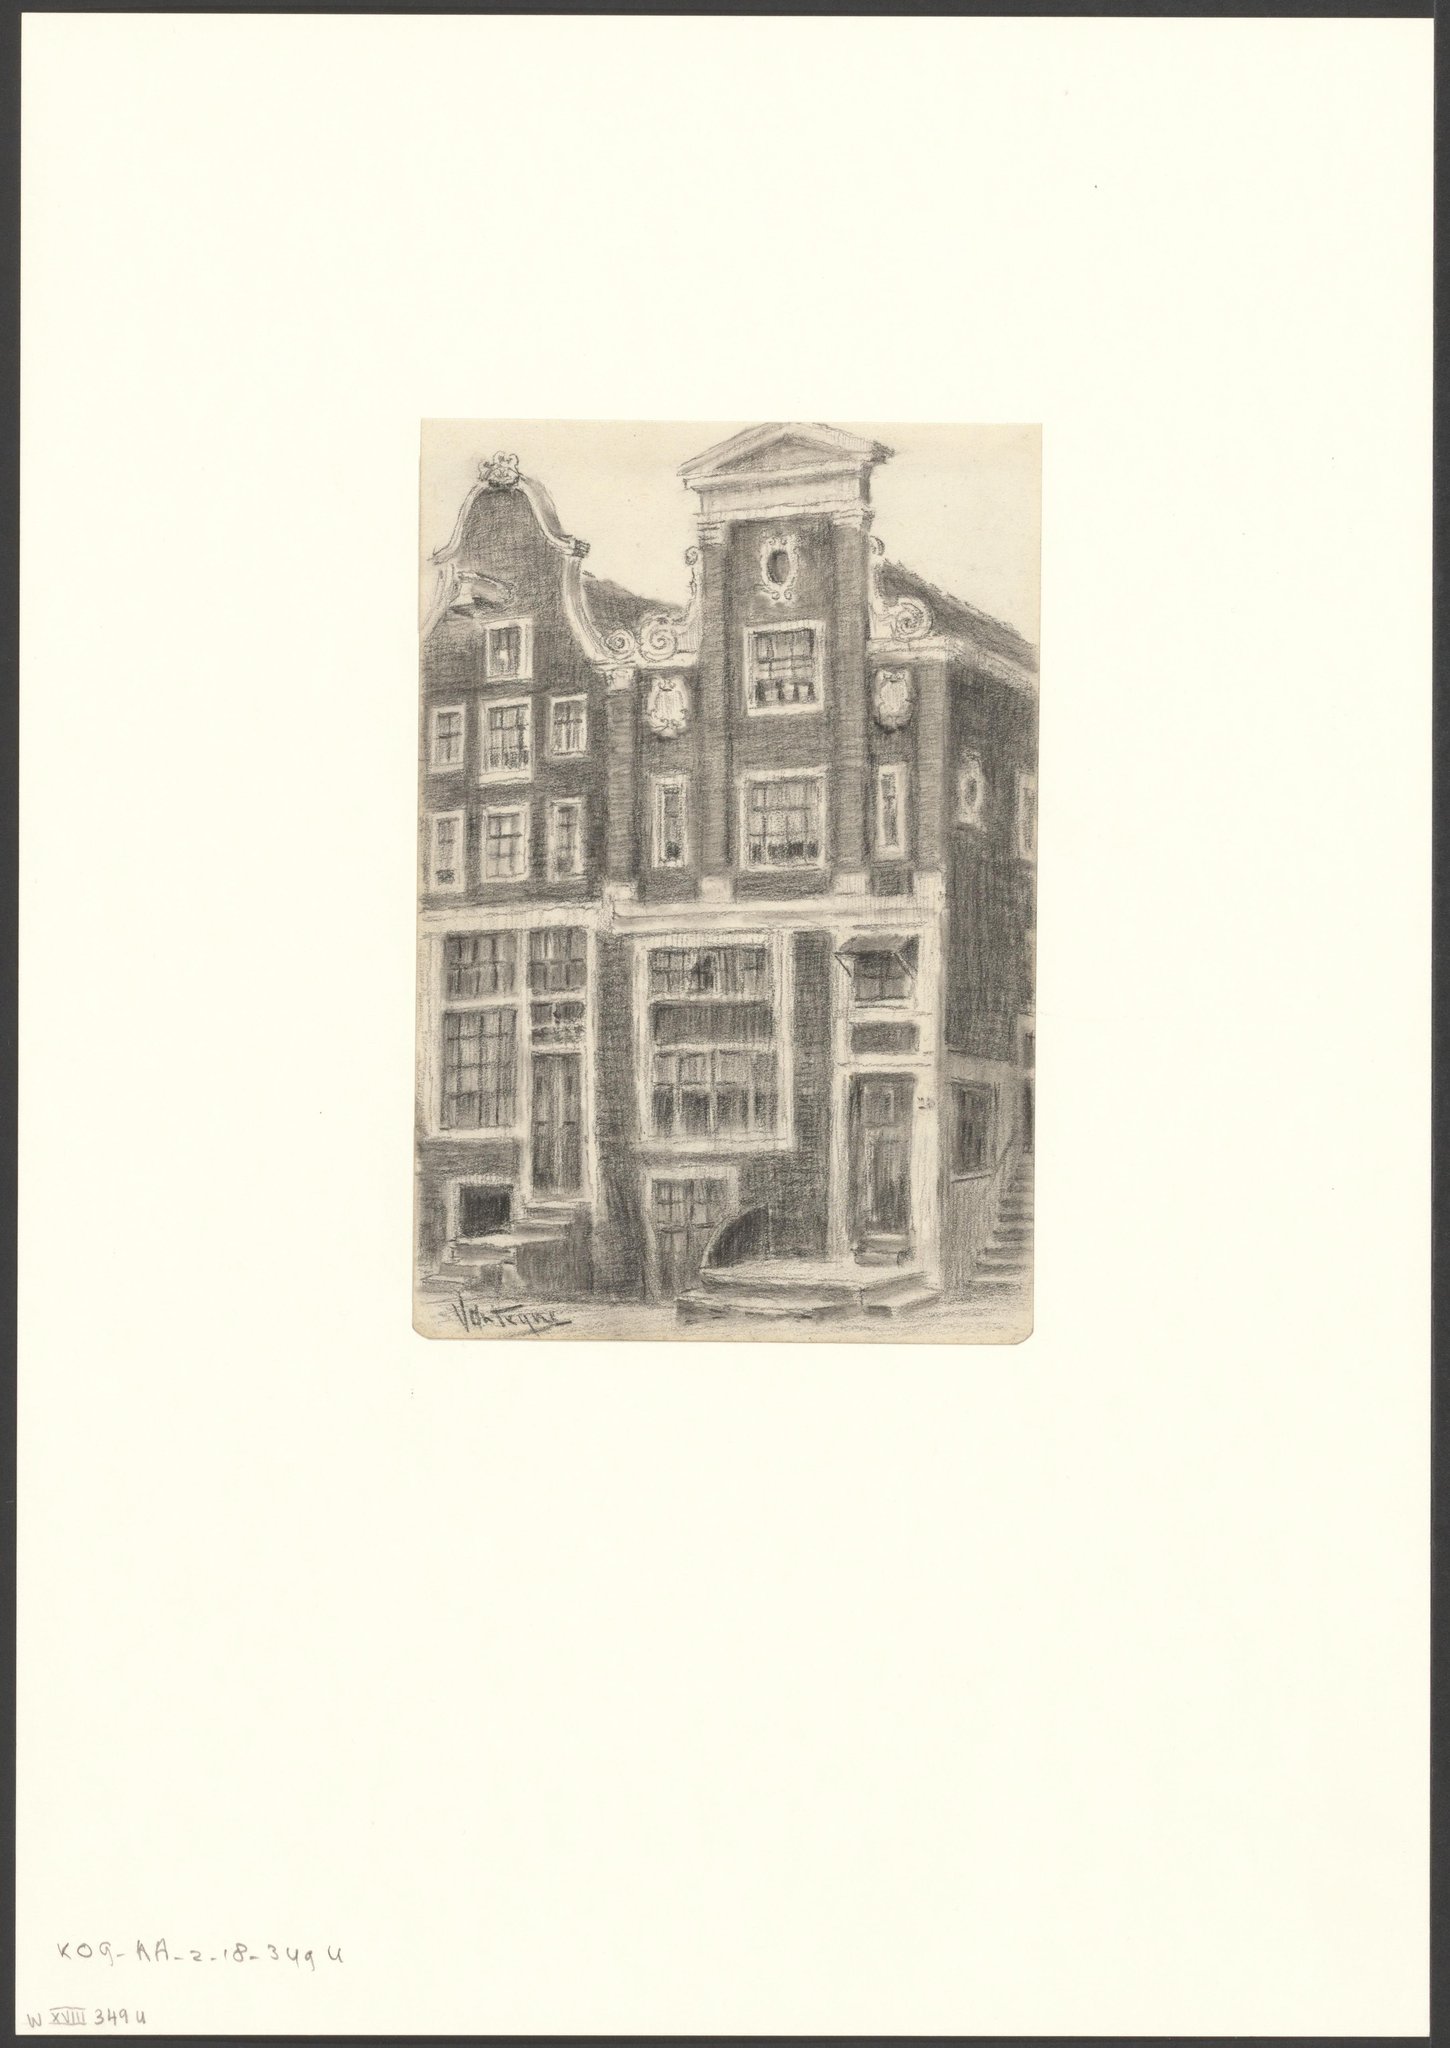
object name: drawing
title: Gezicht op panden aan de Brouwersgracht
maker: anthonie van teijn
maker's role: draughtsman, painter, print maker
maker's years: 1863-1943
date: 1873-1943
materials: chalk, paper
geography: amsterdam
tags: city-view in general; 'veduta', façade (of house or building), street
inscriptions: inscription: ‘hoek Brouwersgracht / Binnen Oranjestraat’, signature: ‘VanTeyne’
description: Tekening binnen de Atlas Van Eck ingedeeld op wijknummer 18.